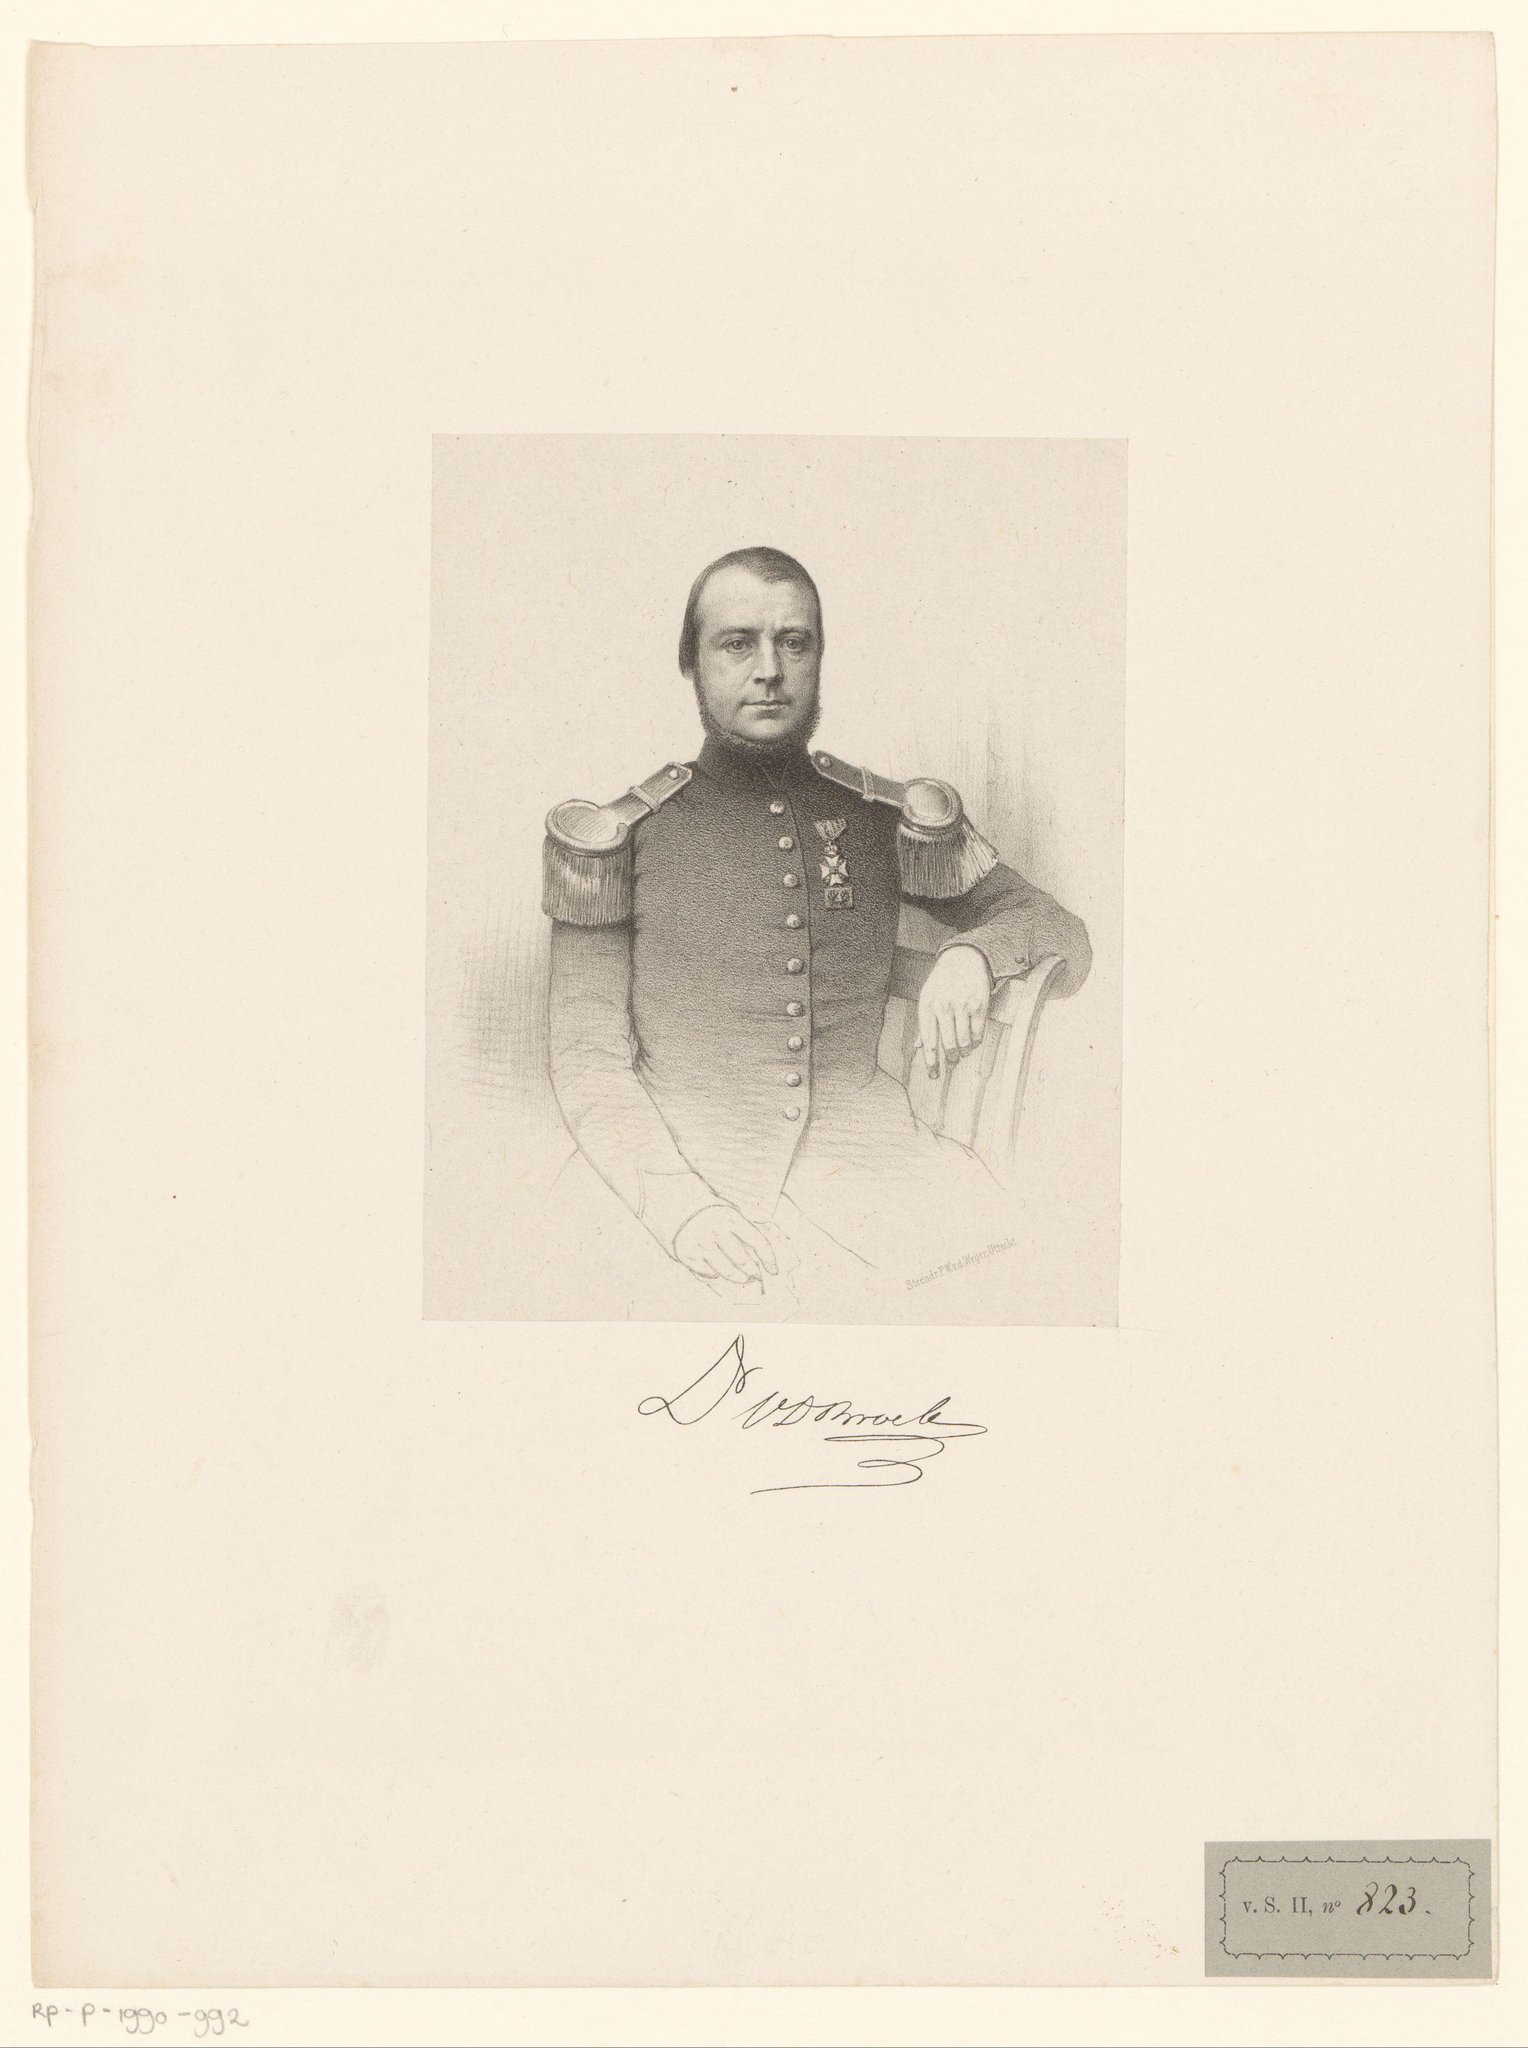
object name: print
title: Portret van Johannes Hubertus van den Broek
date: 1851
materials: paper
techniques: lithograph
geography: utrecht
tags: brussels, knighthood order, historical persons (+ half-length portrait)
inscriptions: collector's mark: Lugt 2228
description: De geportretteerde draagt een militair uniform met ridderode en ereteken voor vijftienjarige dienst. Onder het portret zijn signatuur.